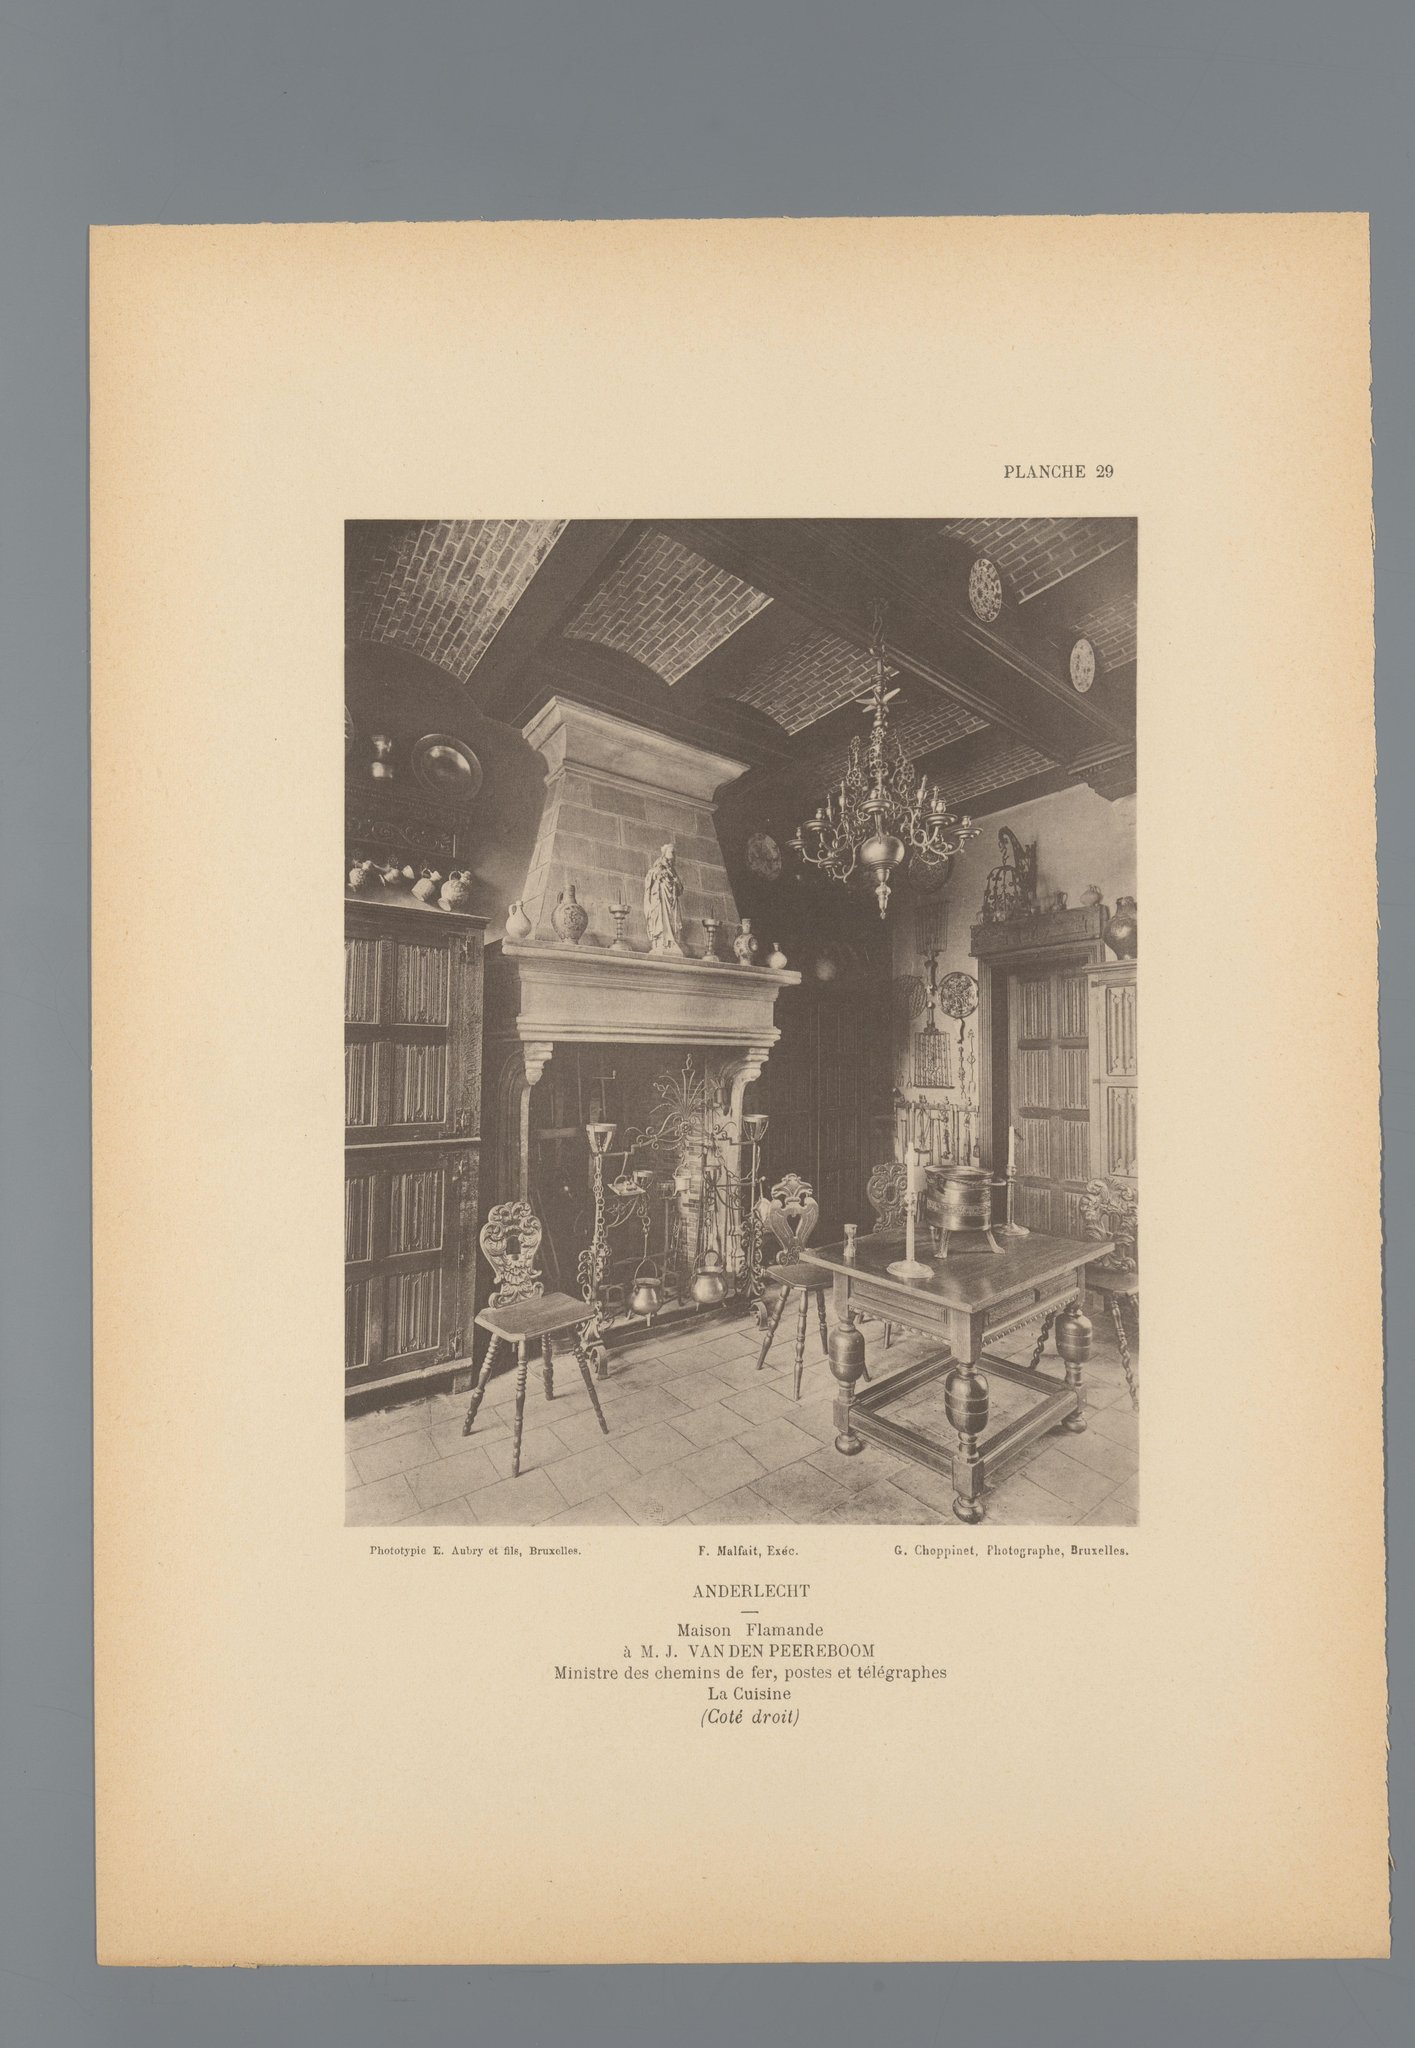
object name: photomechanical print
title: Anderlecht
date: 1893-1898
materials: paper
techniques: photograph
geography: brussels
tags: kitchen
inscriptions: number: ‘PLANCHE 29’, name: ‘F. Malfait, Exéc.’, inscription: ‘Maison Flamande/ à M. J. VANDEN PEEREBOOM/ Ministre des chemins de fer, postes et télégraphes/ La Cuisine/ (Coté droit)’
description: Deze prent maakt deel uit van een omslag met 89 prenten en 5 tekstbladen.